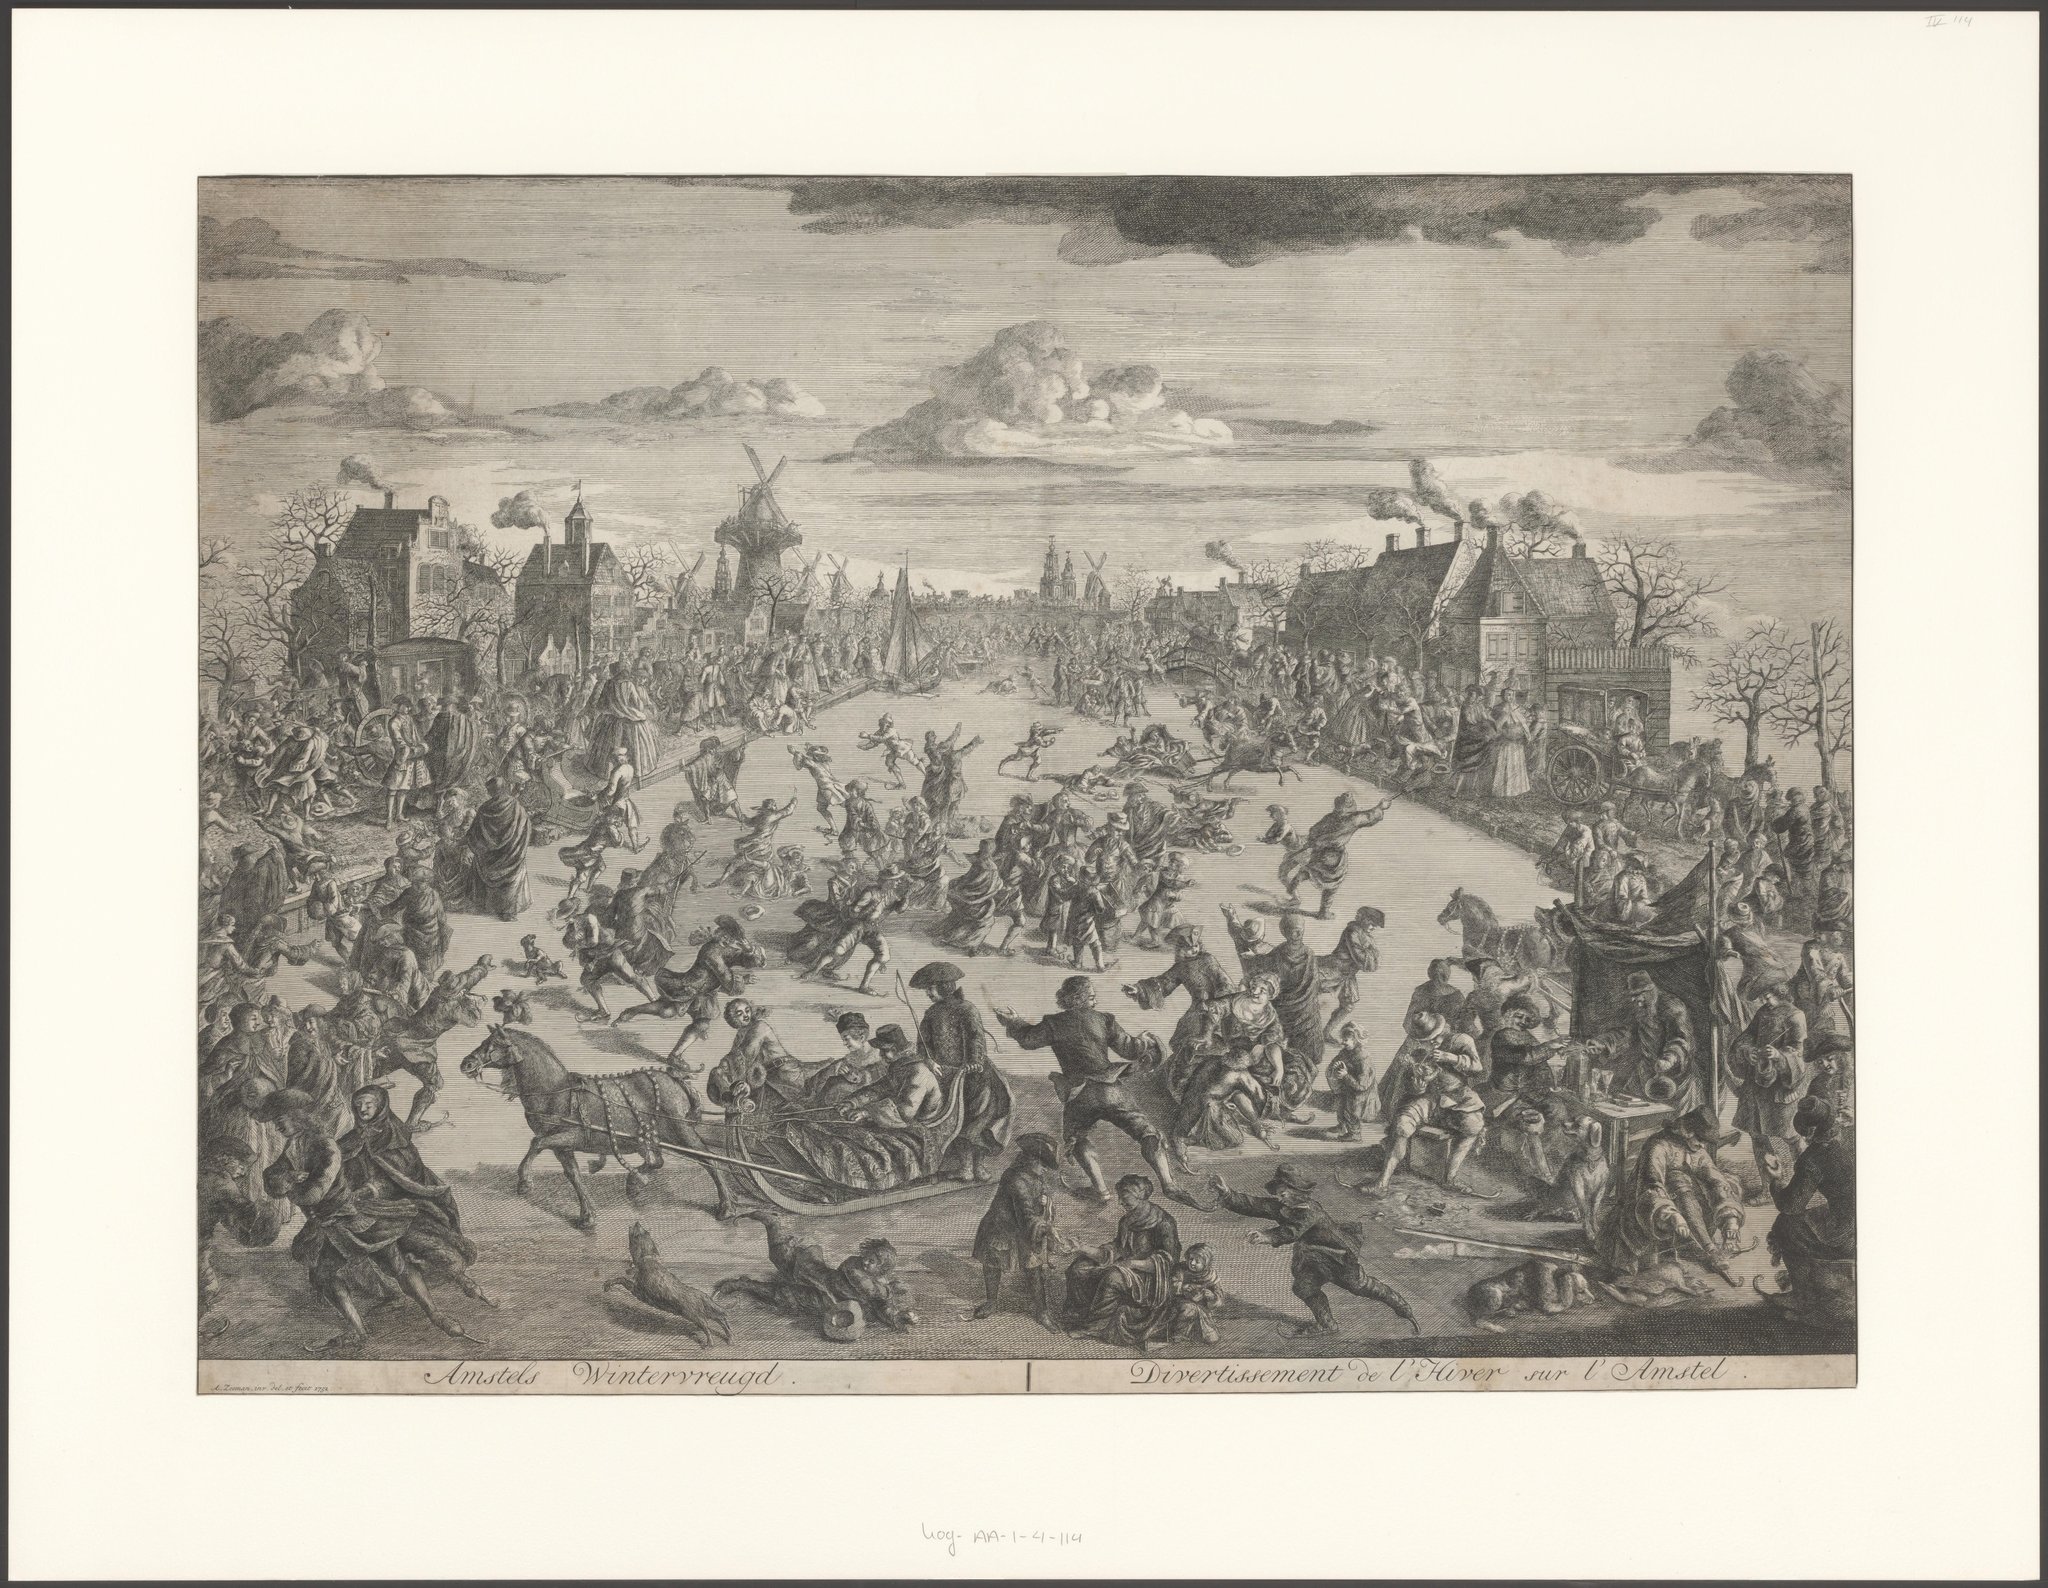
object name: print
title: Amstels Wintervreugd / Divertissement de l'Hiver sur l'Amstel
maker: abraham zeeman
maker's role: print maker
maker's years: 1695-1754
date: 1752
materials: paper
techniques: engraving, etching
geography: amsterdam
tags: city-view in general; 'veduta', river, winter landscape; landscape symbolizing winter (the four seasons of the year), skates (winter sports), bridge in city across river, canal, etc.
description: Onderwerpsrubriek binnen de Atlas Amsterdam: Amstel van Hogesluis stroomopwaarts. Genummerd rechtsboven: 2.